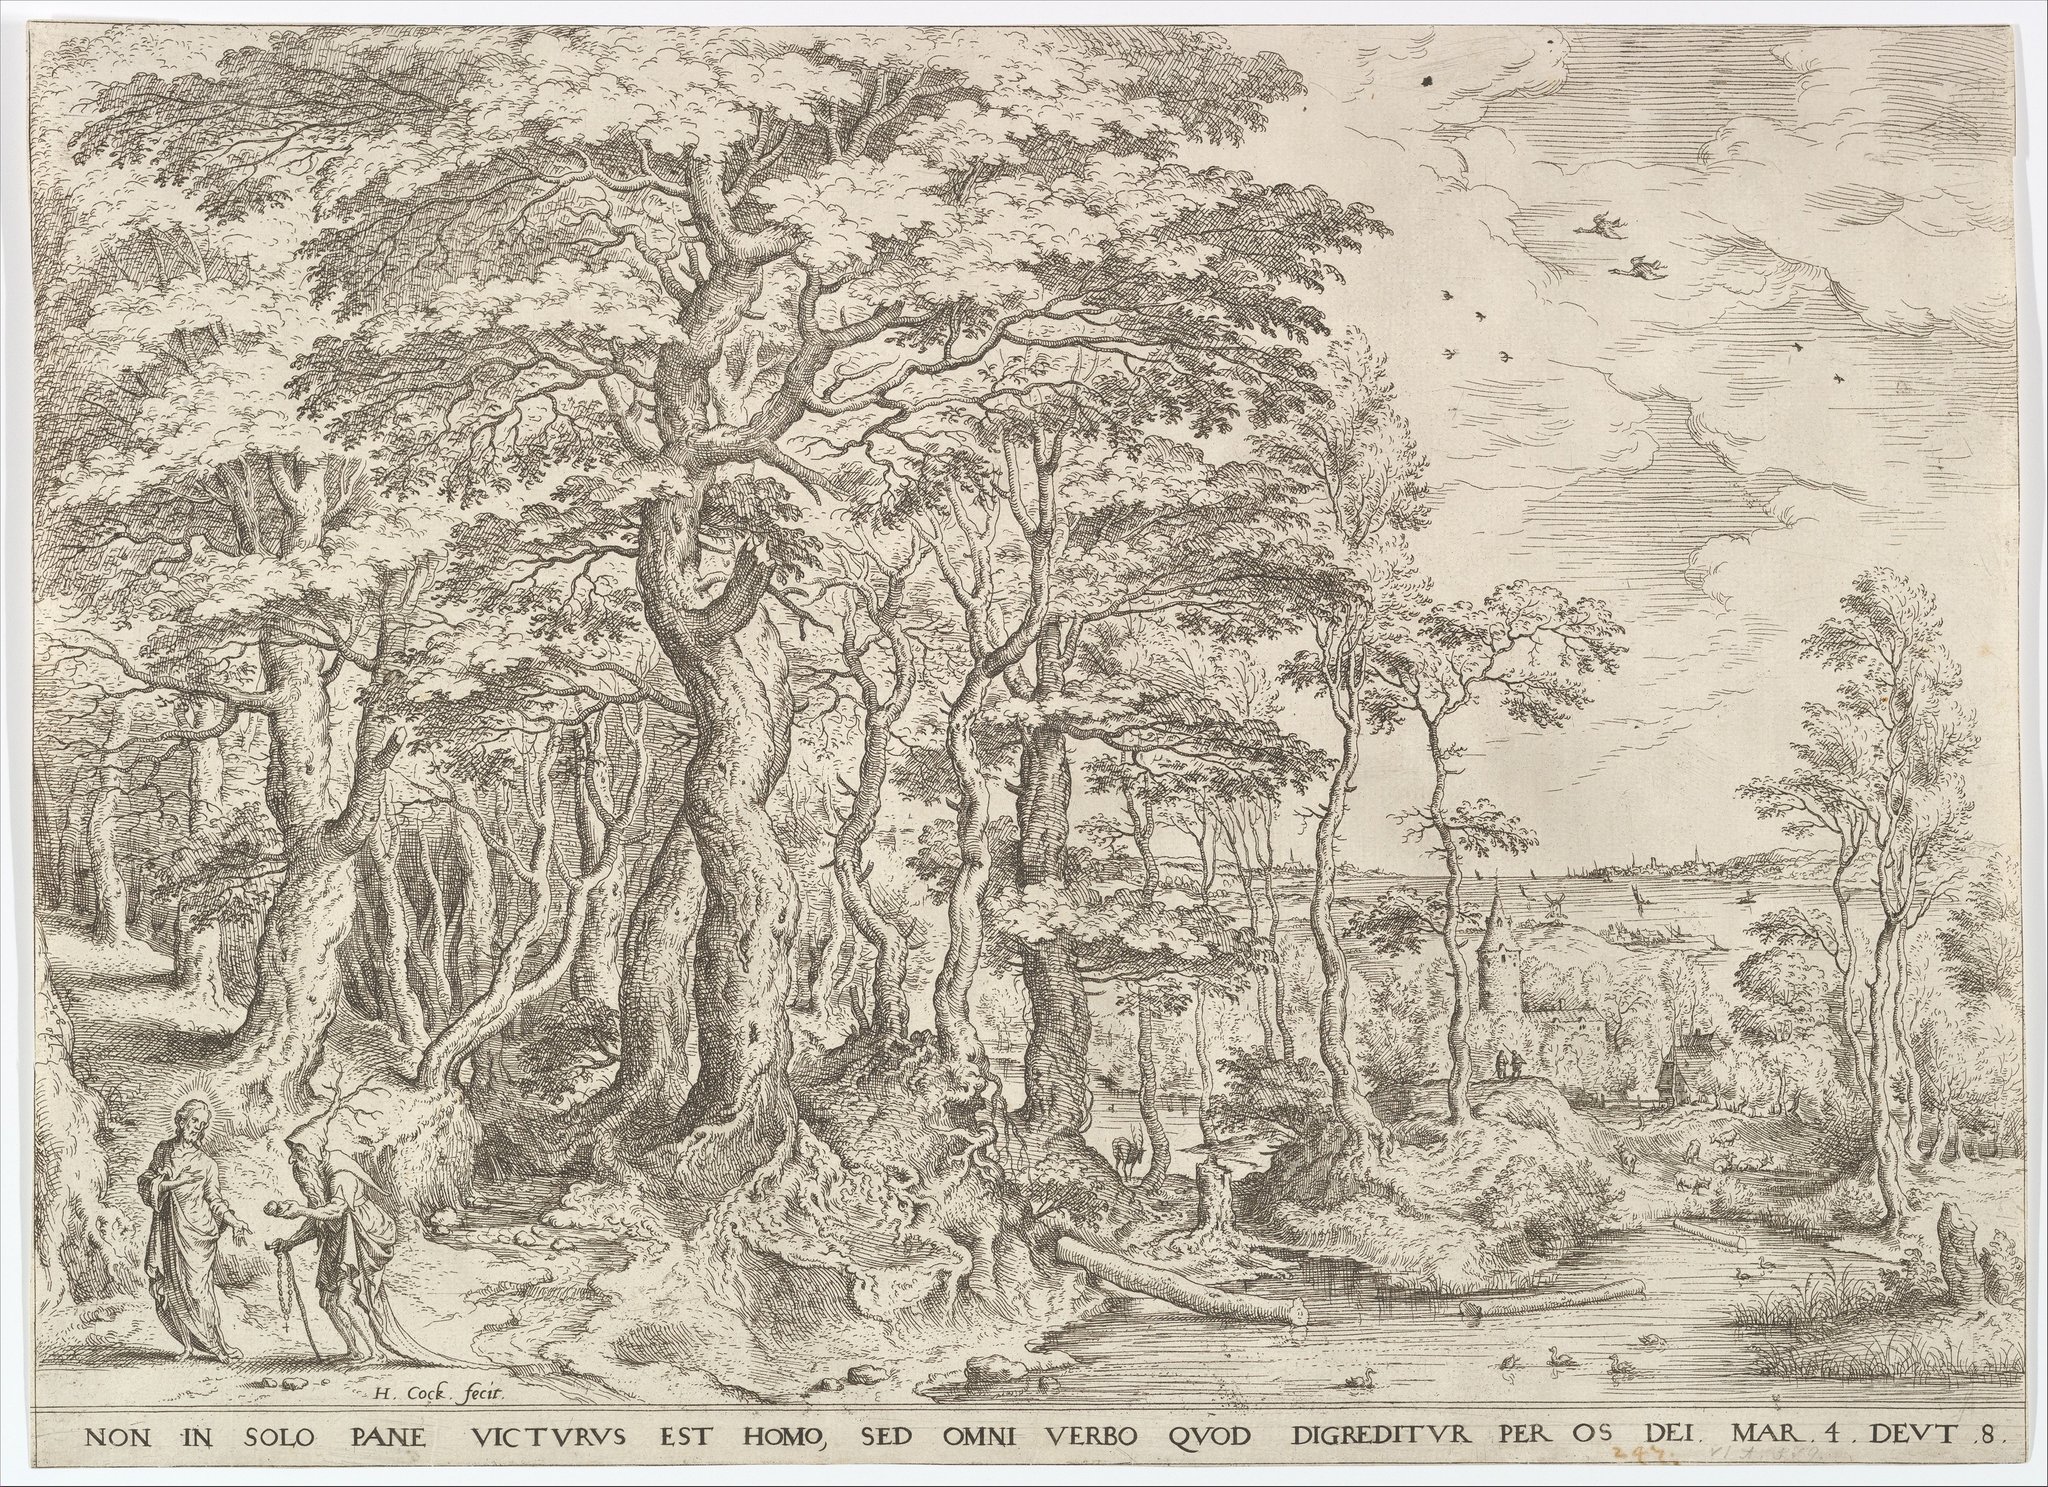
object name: print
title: Landscape with the Temptation of Christ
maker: hieronymus cock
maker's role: artist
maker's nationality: netherlandish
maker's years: 1510-1570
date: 1554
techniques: etching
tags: landscapes,christ